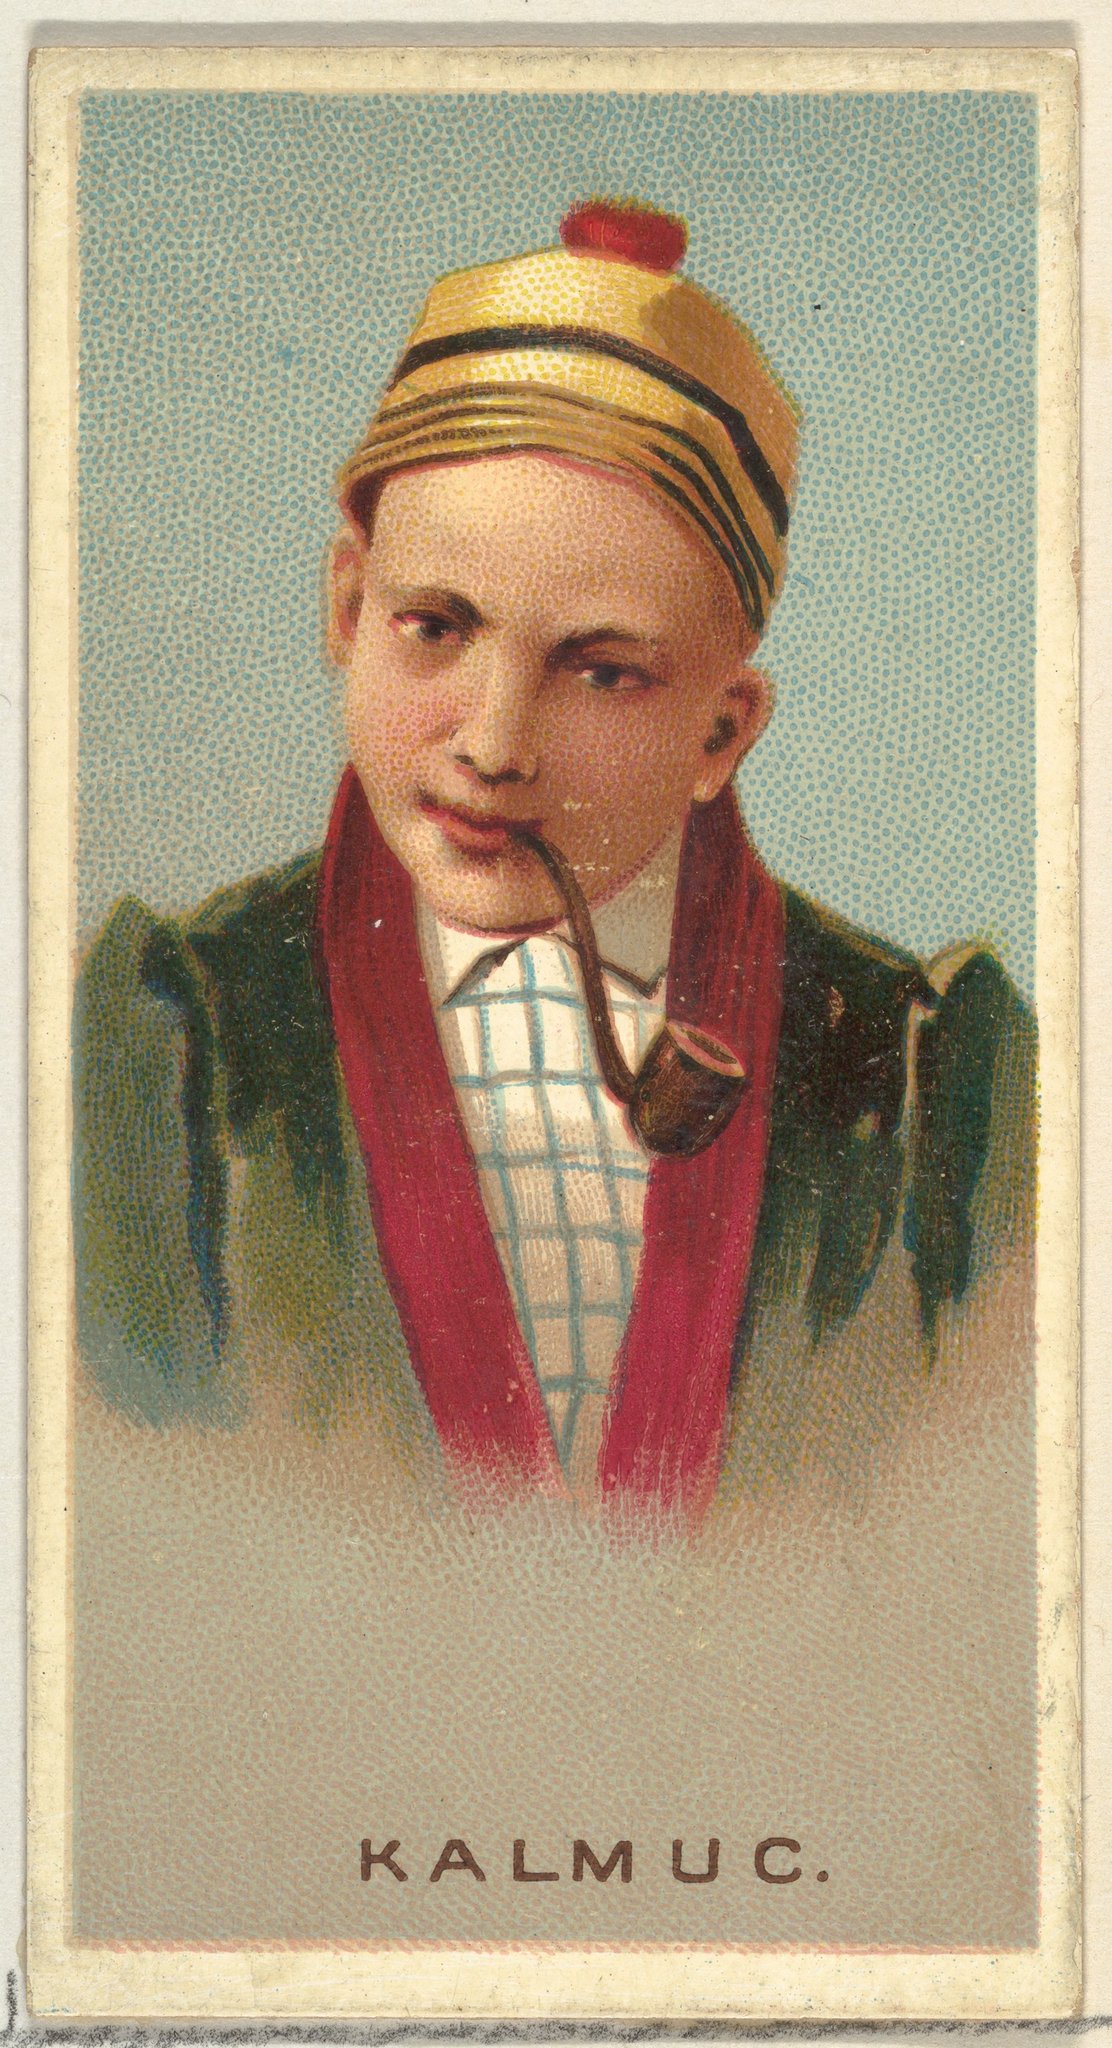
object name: print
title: Kalmuc, from World's Smokers series (N33) for Allen & Ginter Cigarettes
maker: allen & ginter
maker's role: publisher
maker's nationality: american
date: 1888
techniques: color lithograph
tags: men,smoking